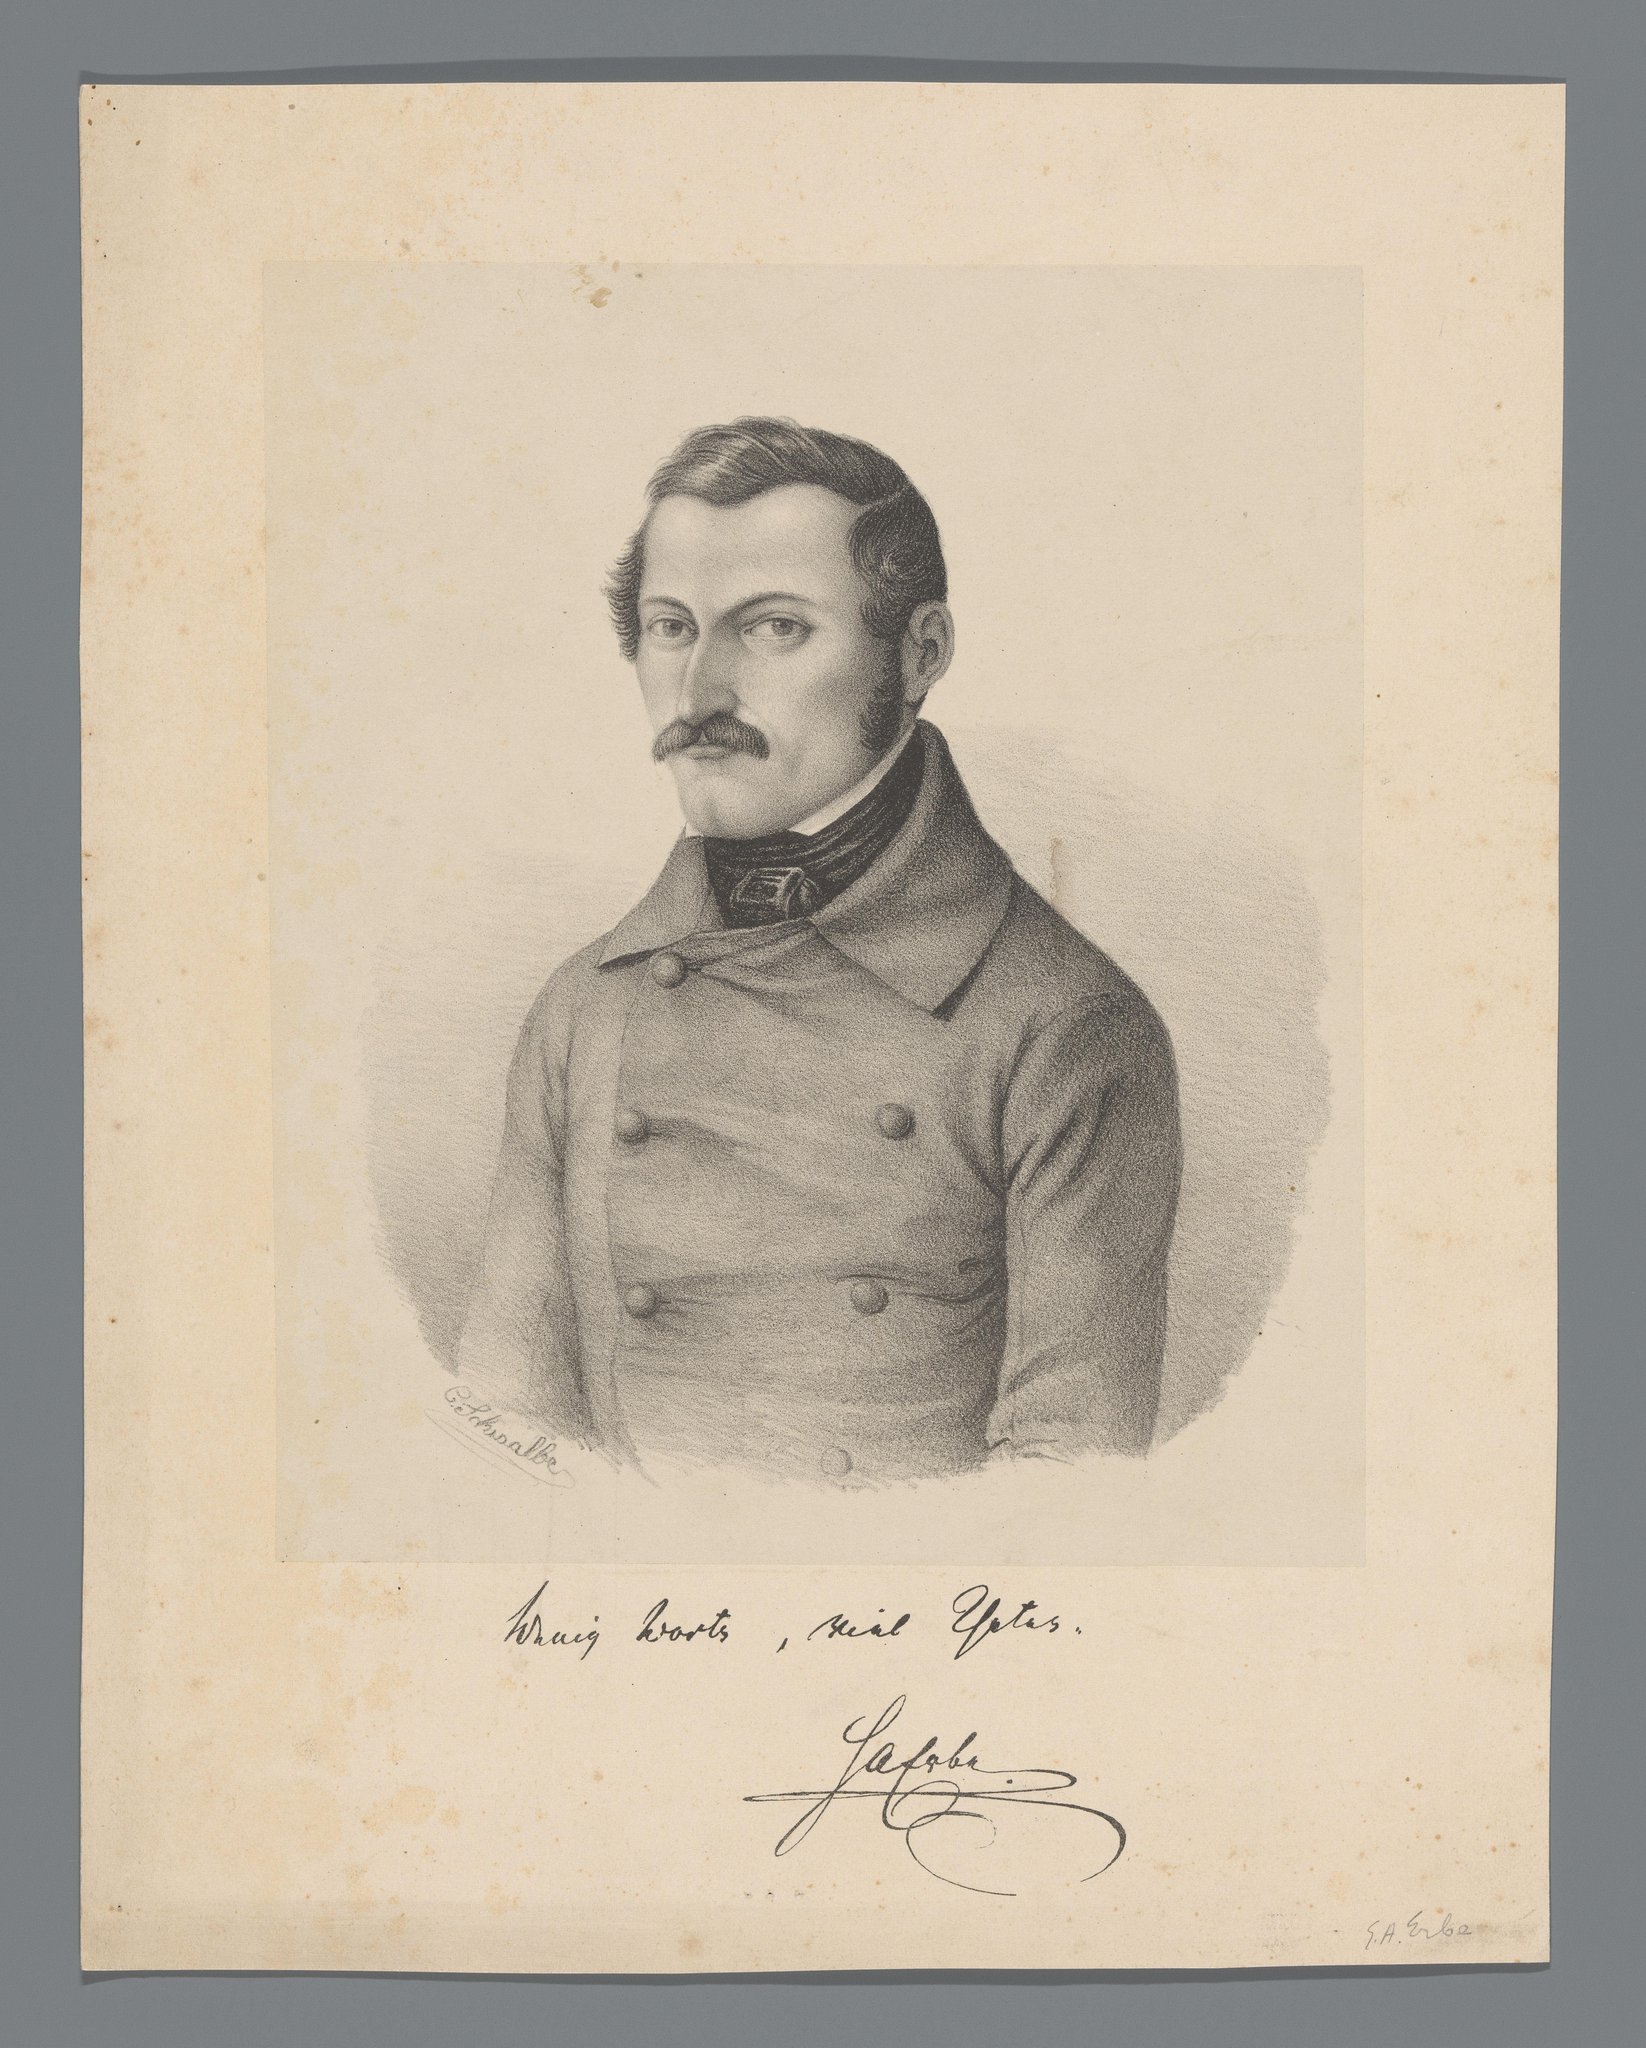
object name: print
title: Portret van een onbekende man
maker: c. schwalbe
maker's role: print maker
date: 1820-1860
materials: paper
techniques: lithograph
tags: moustache, adult man, historical persons